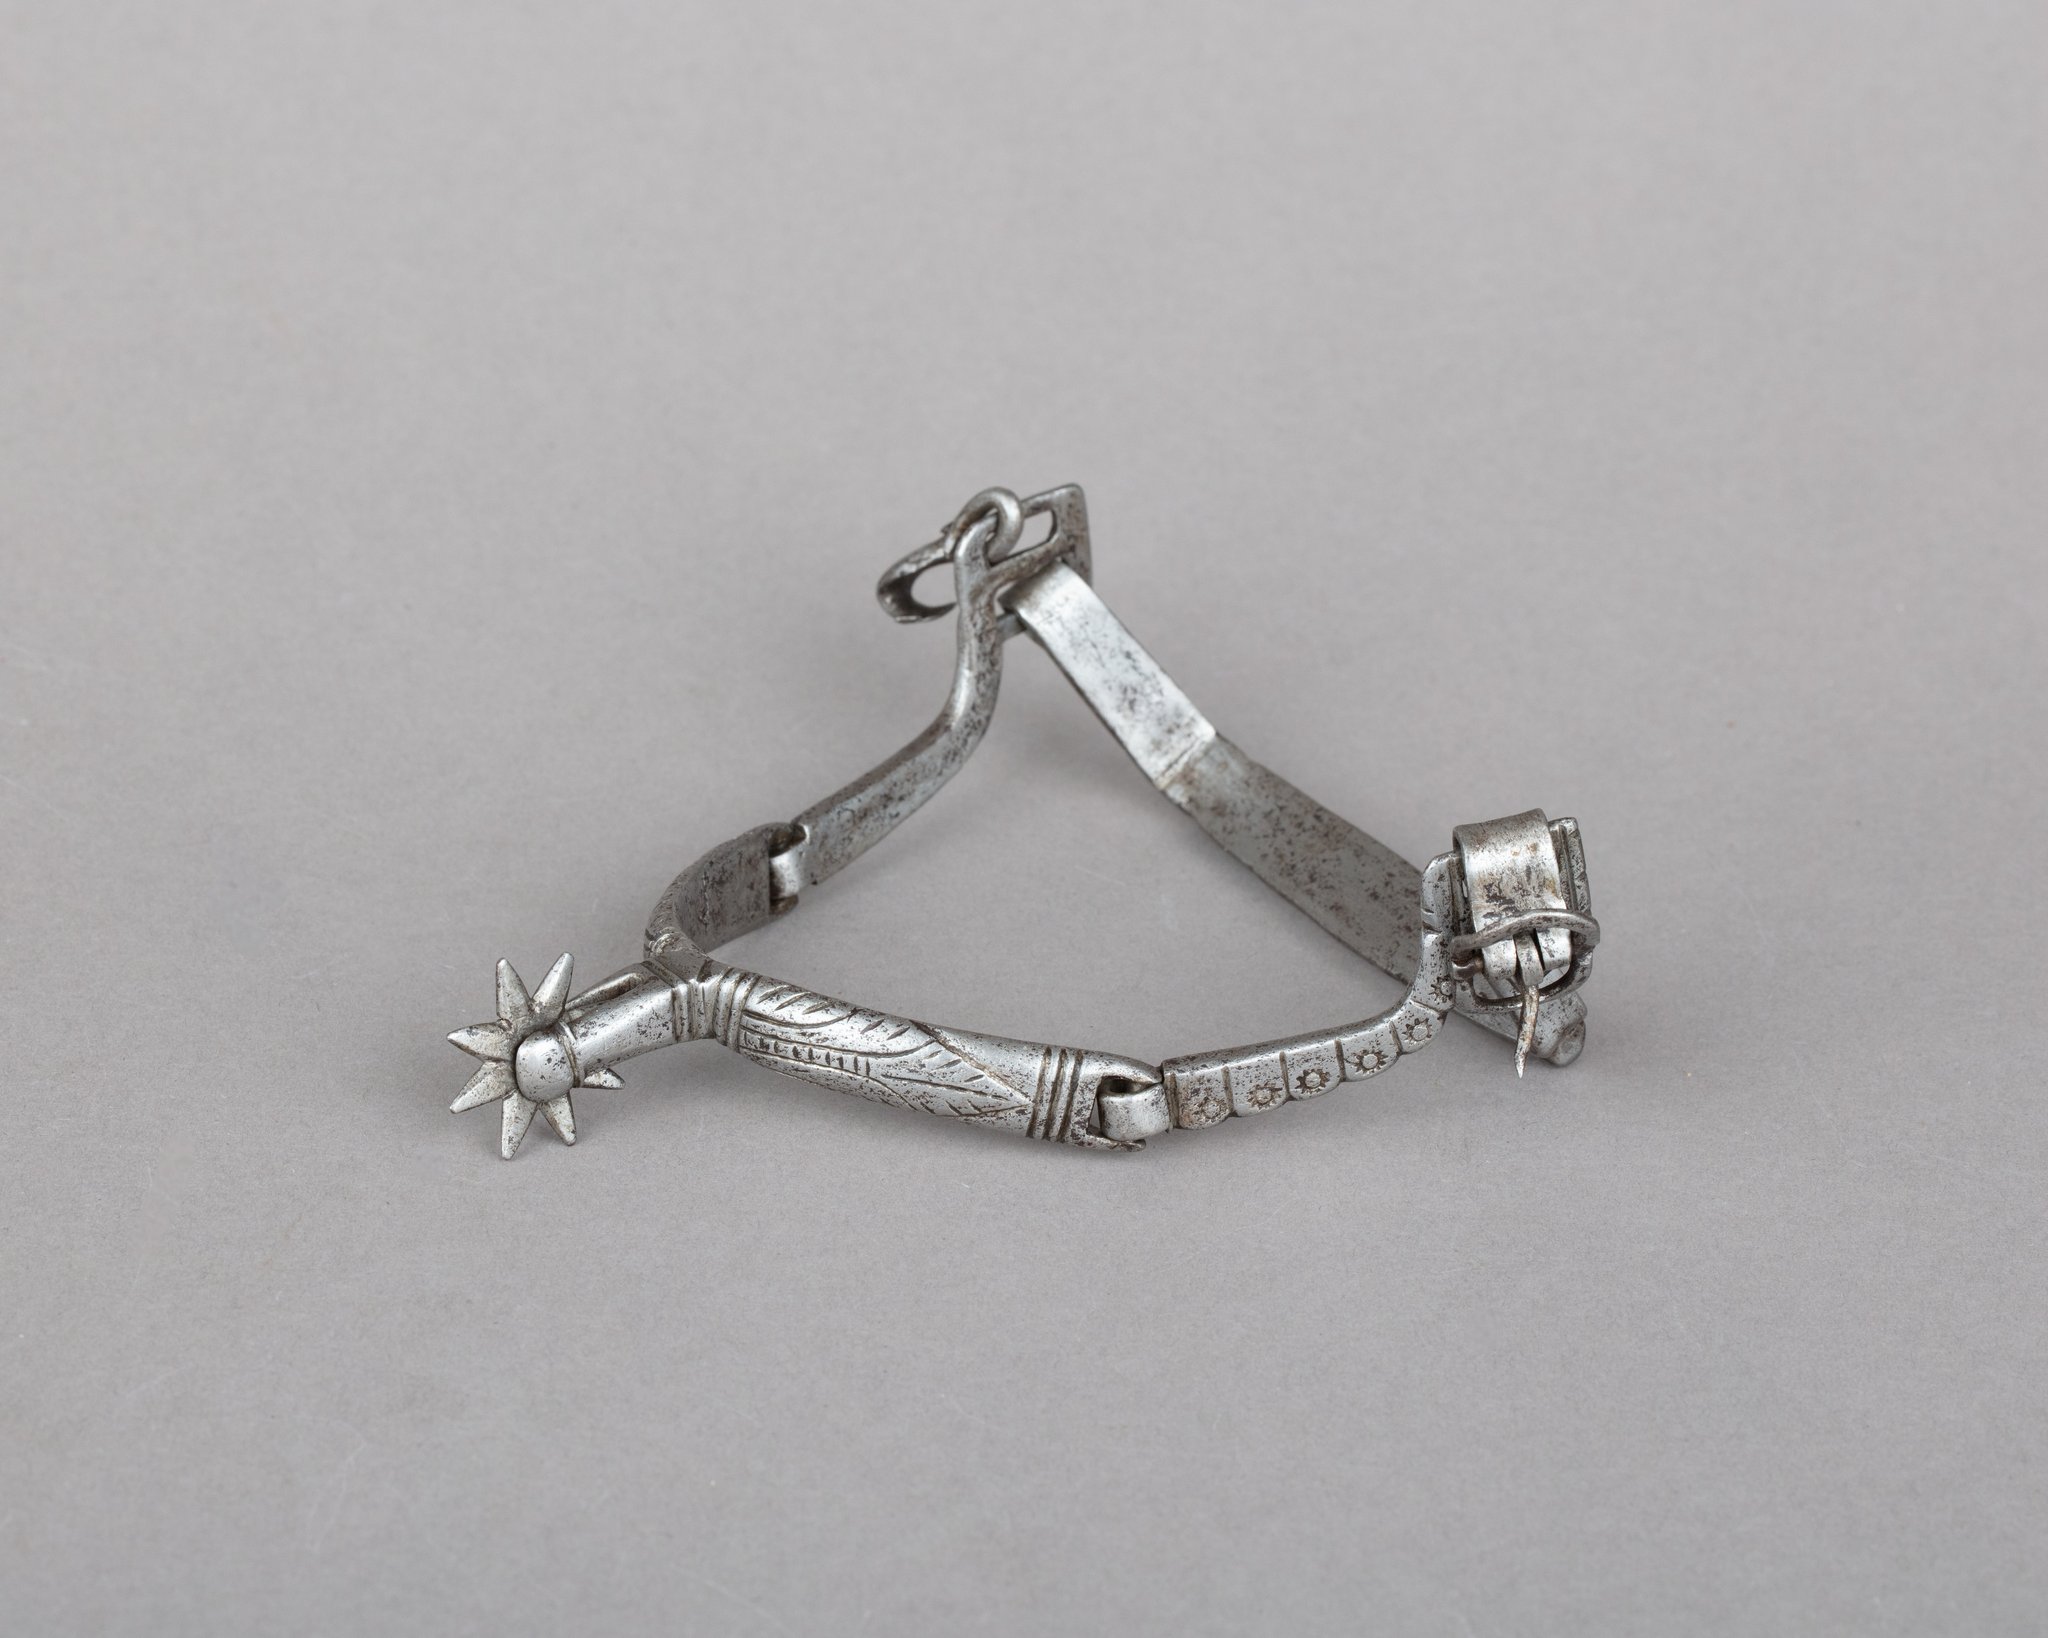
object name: spur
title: Rowel Spur (Right)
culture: german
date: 1601-1633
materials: metal alloy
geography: germany